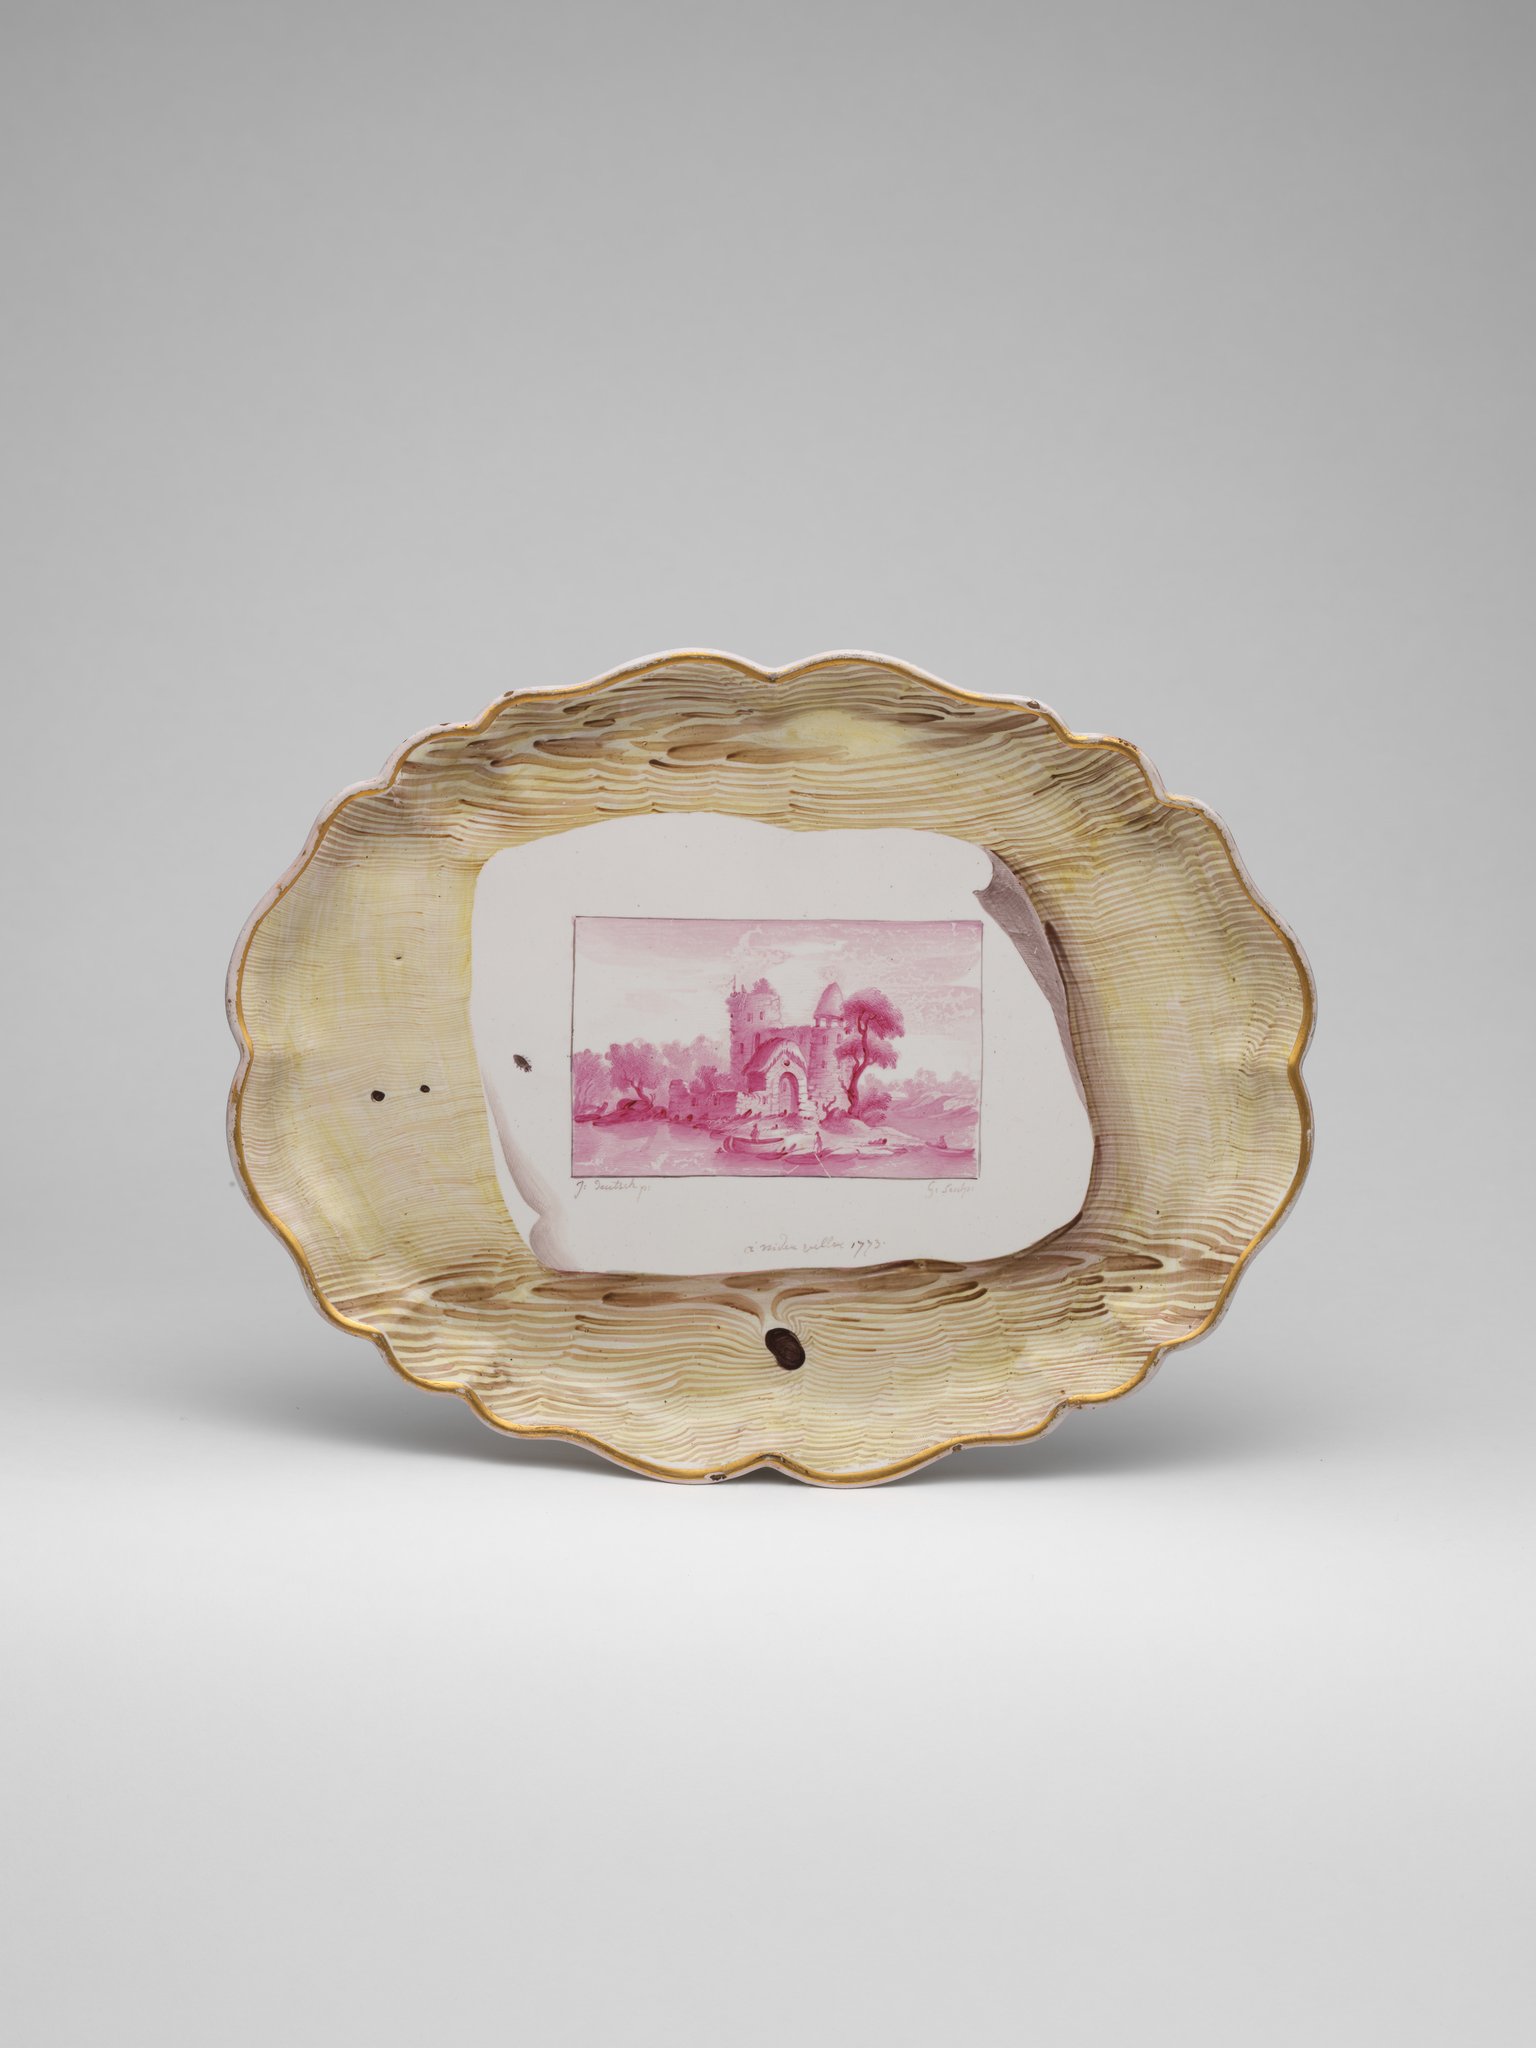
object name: tray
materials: faience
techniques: glazing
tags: houses,trees